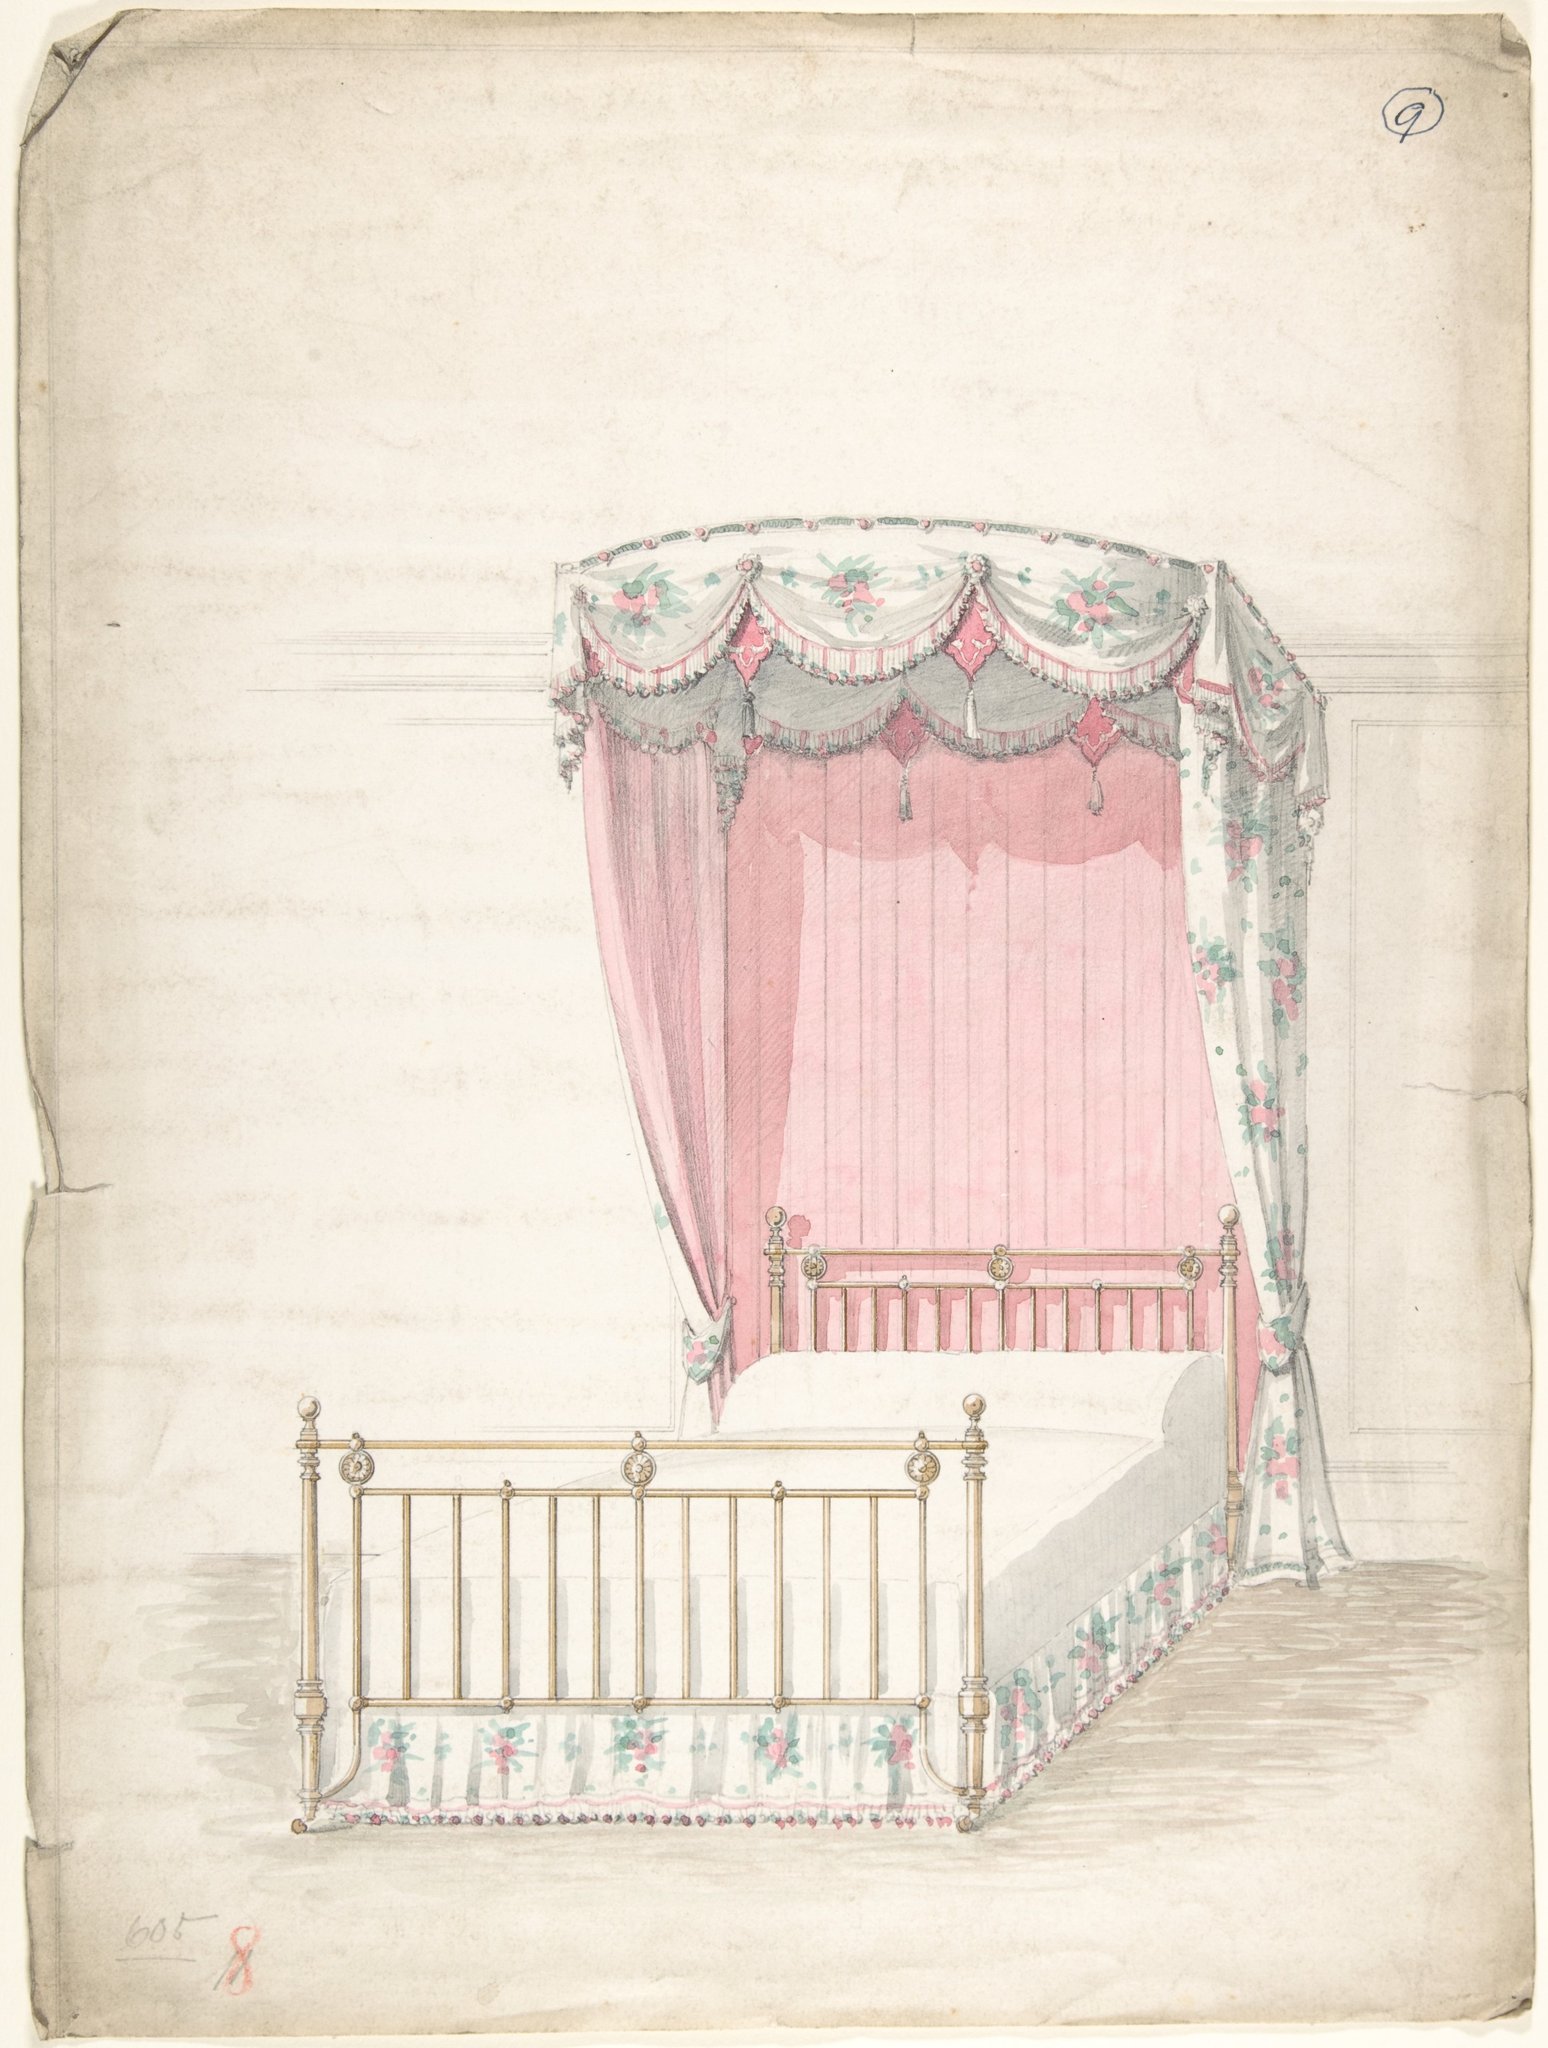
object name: drawing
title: Design for a Bed and Canopy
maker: charles hindley and sons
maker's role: artist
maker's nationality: british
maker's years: 1841-1917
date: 1841-1917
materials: graphite, watercolor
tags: beds